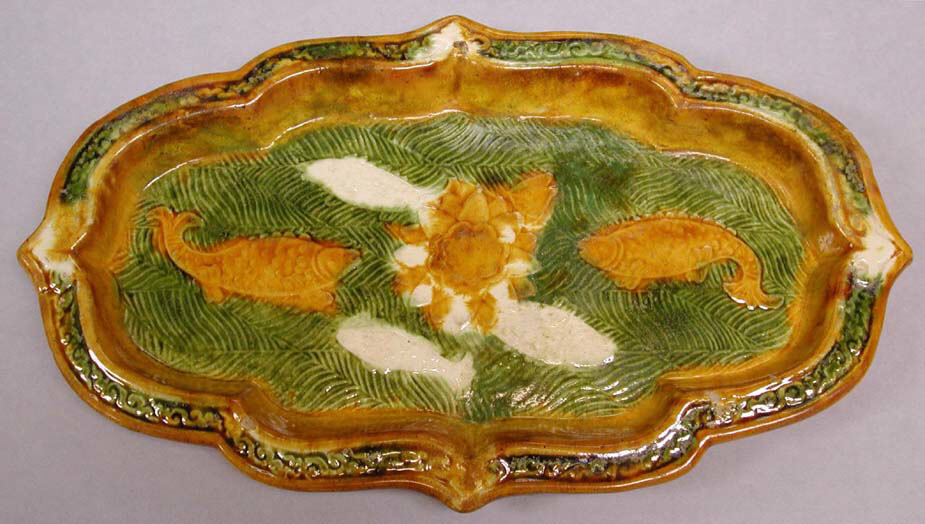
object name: dish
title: Oblong dish with foliate rim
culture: chinese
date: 1051-1100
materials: earthenware, glaze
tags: fish,flowers